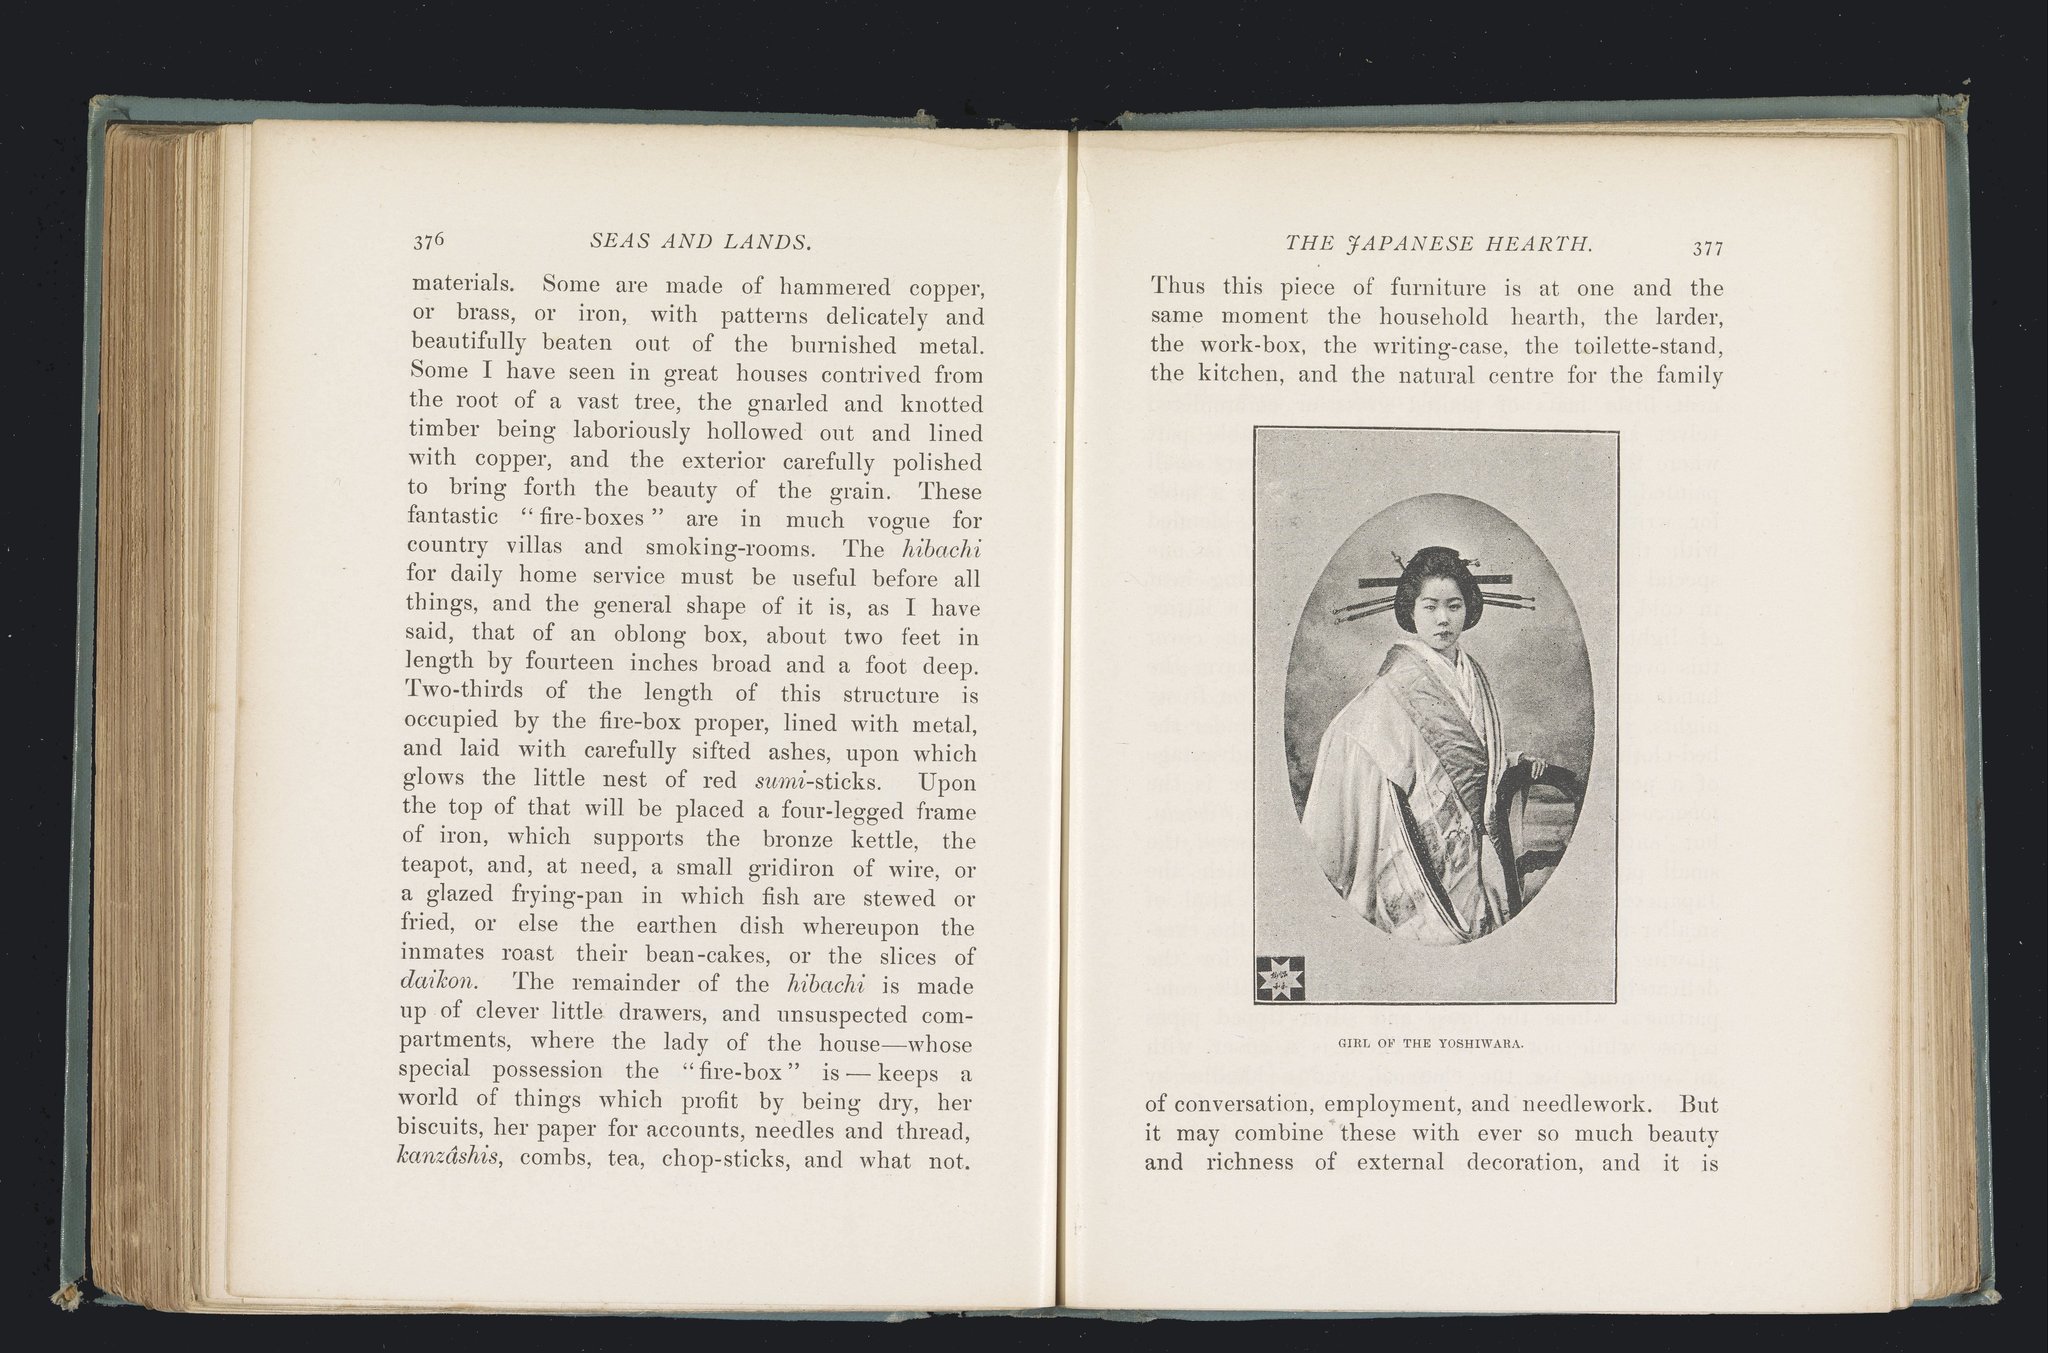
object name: photomechanical print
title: Girl of the Yoshiwara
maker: Anonymous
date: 1882-1892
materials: paper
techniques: autotype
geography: tokyo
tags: adult woman, folk costume, regional costume